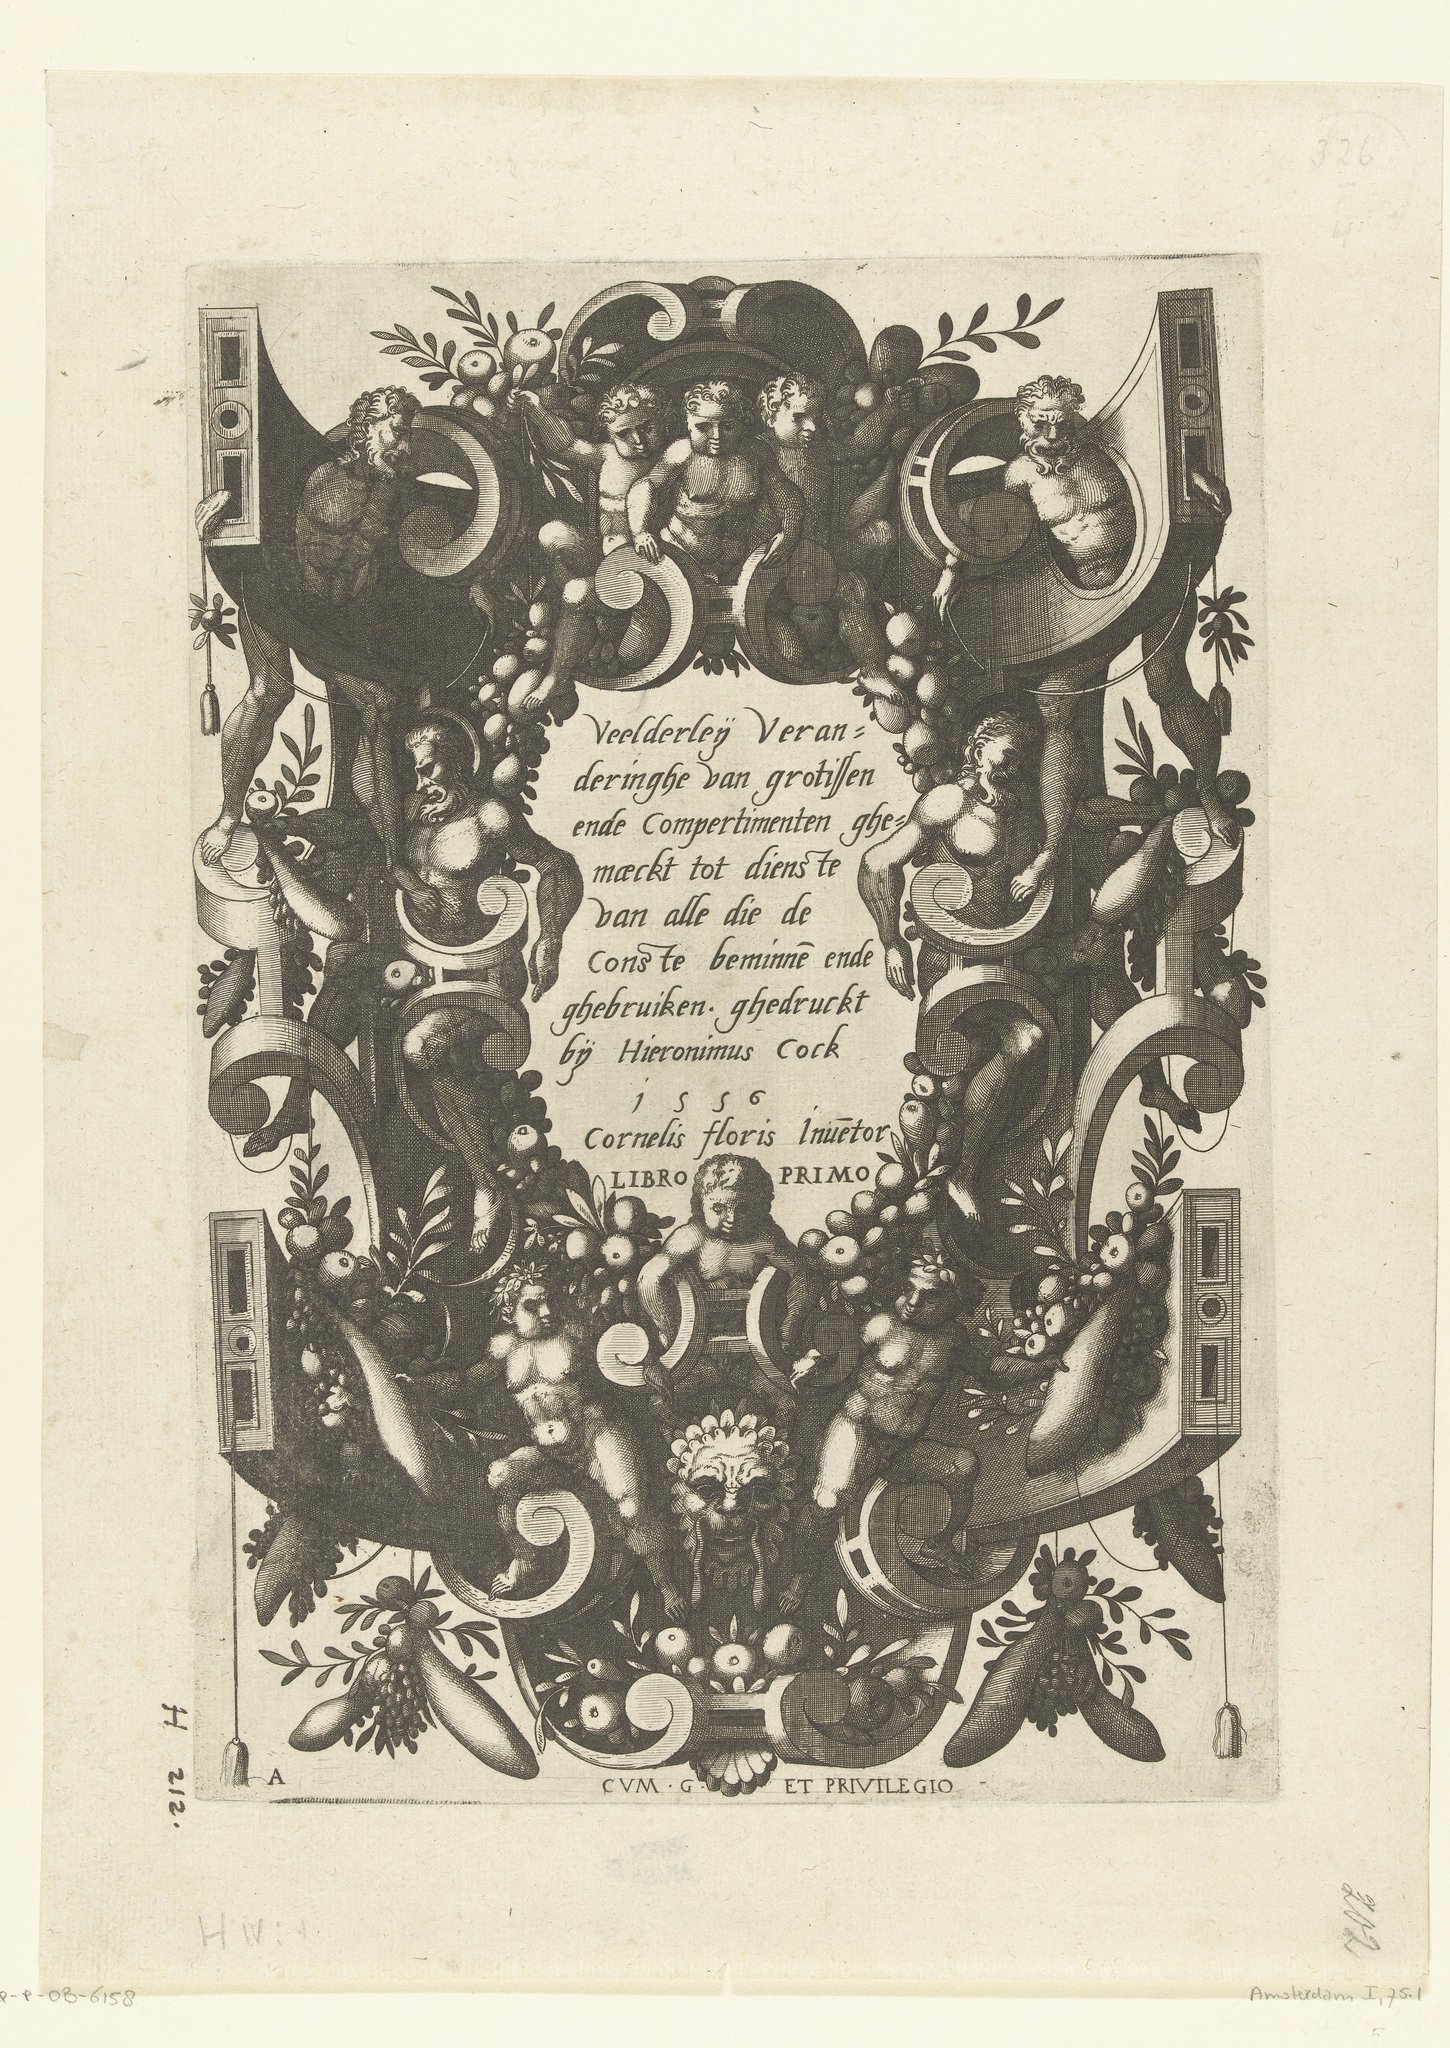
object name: titelprent, frontispice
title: Veelderleij Veranderinghe van grotissen ende Compertimenten (...)Libro Primo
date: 1556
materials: paper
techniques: etching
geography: netherlands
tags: scrollwork, strapwork ~ ornament, foliage, tendrils, branches ~ ornament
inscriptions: signature: ‘Cornelis floris Inve[n]tor’, date: ‘1556’, address: ‘ghedruckt bij Hieronimus Cock’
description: Cartouche in omlijsting van rolwerk met kindertjes, vruchtenguirlandes en vier mannen. Titel in cartouche: ghedruckt bij Hieronymus Cock, 1556. Blad A afkomstig uit serie van 12 bladen, genummerd A-M.